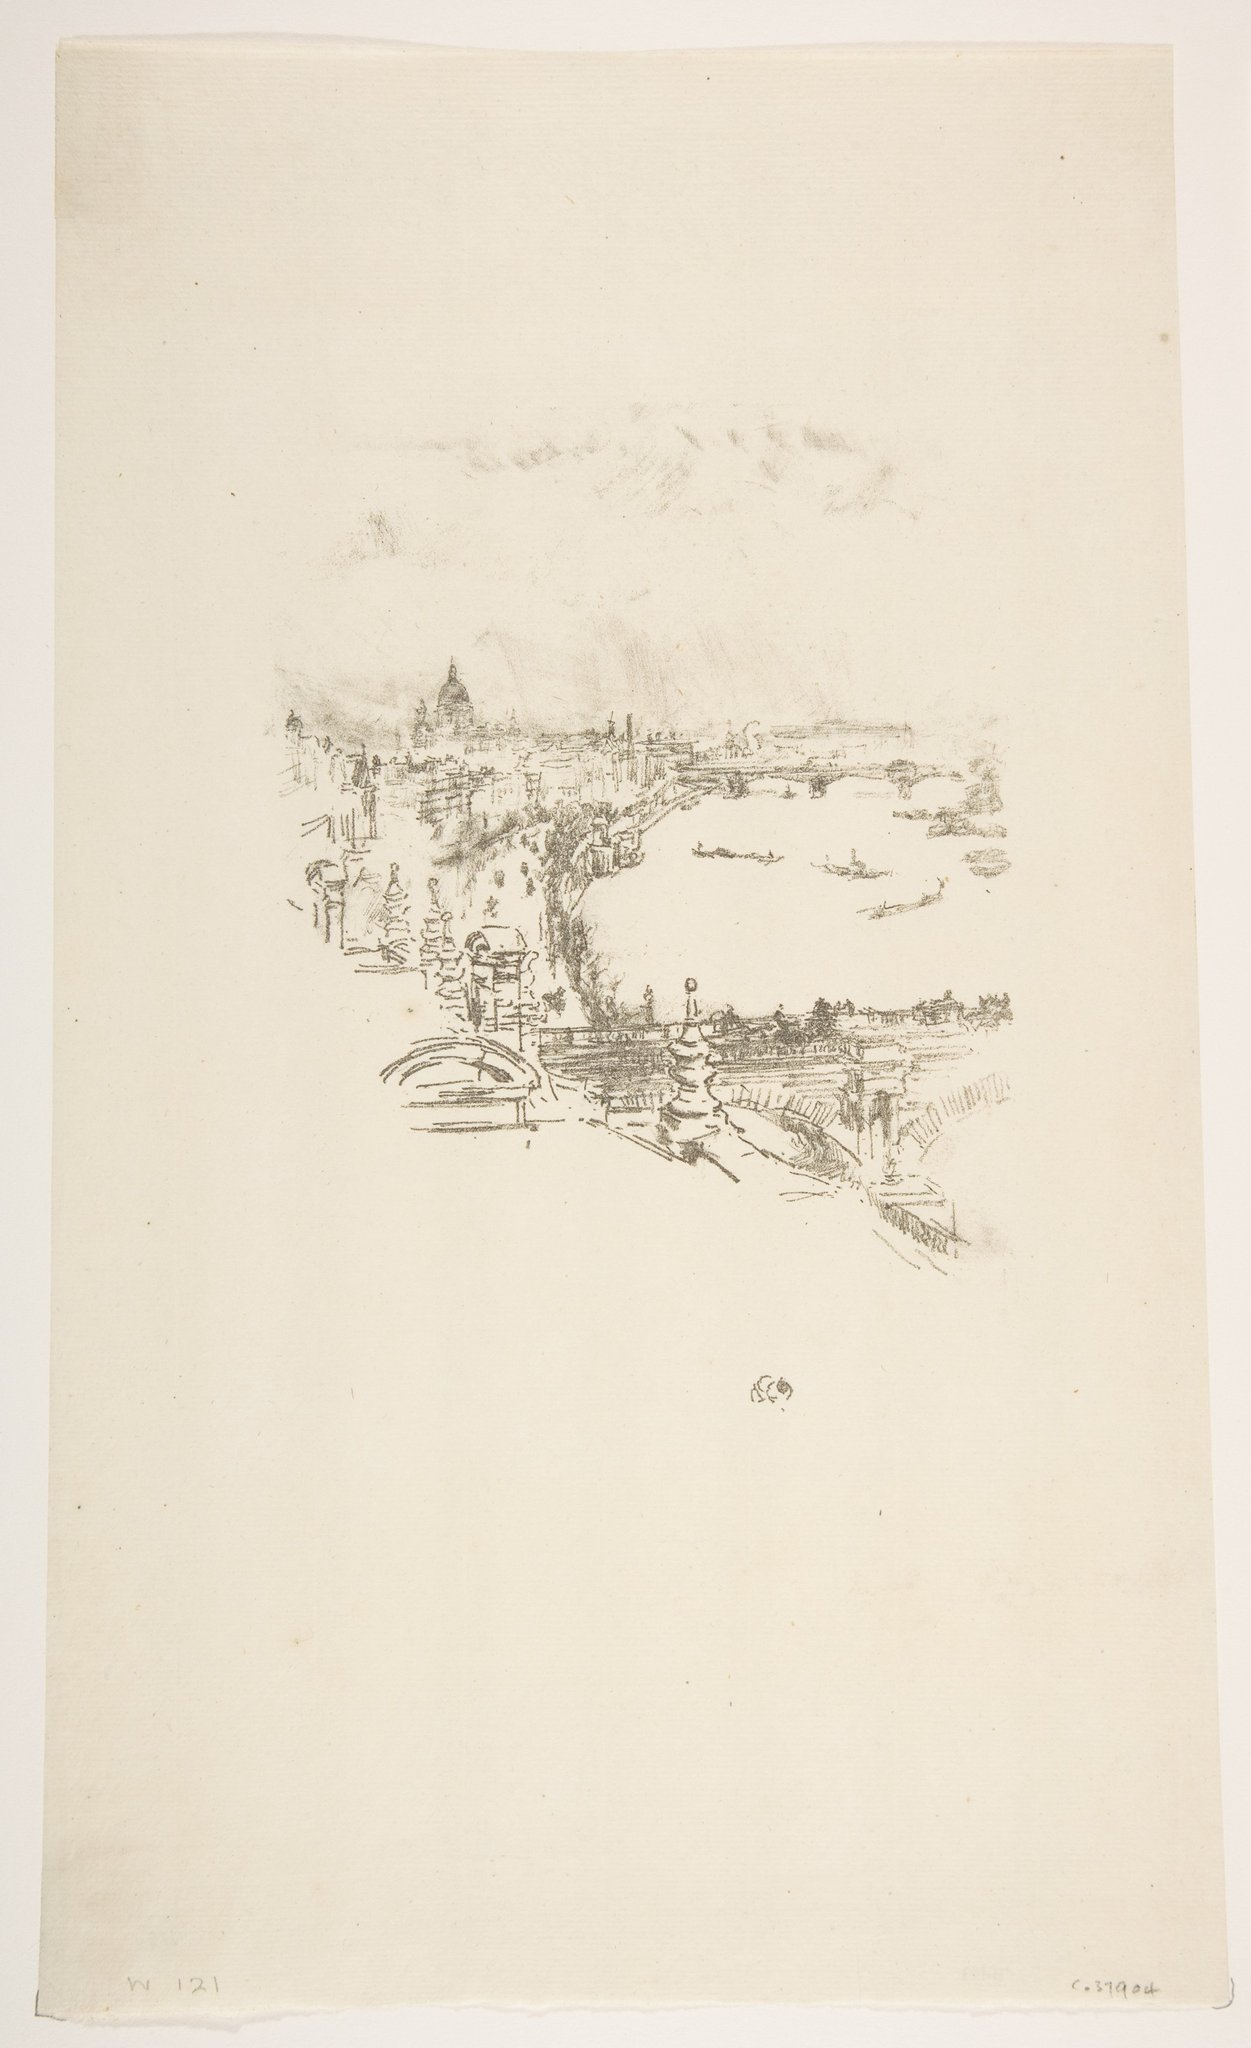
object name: print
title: Little London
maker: james mcneill whistler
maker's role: artist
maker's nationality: american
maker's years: 1834-1903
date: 1896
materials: ink, paper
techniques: printing, stumping, lithography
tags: cities,rivers,london